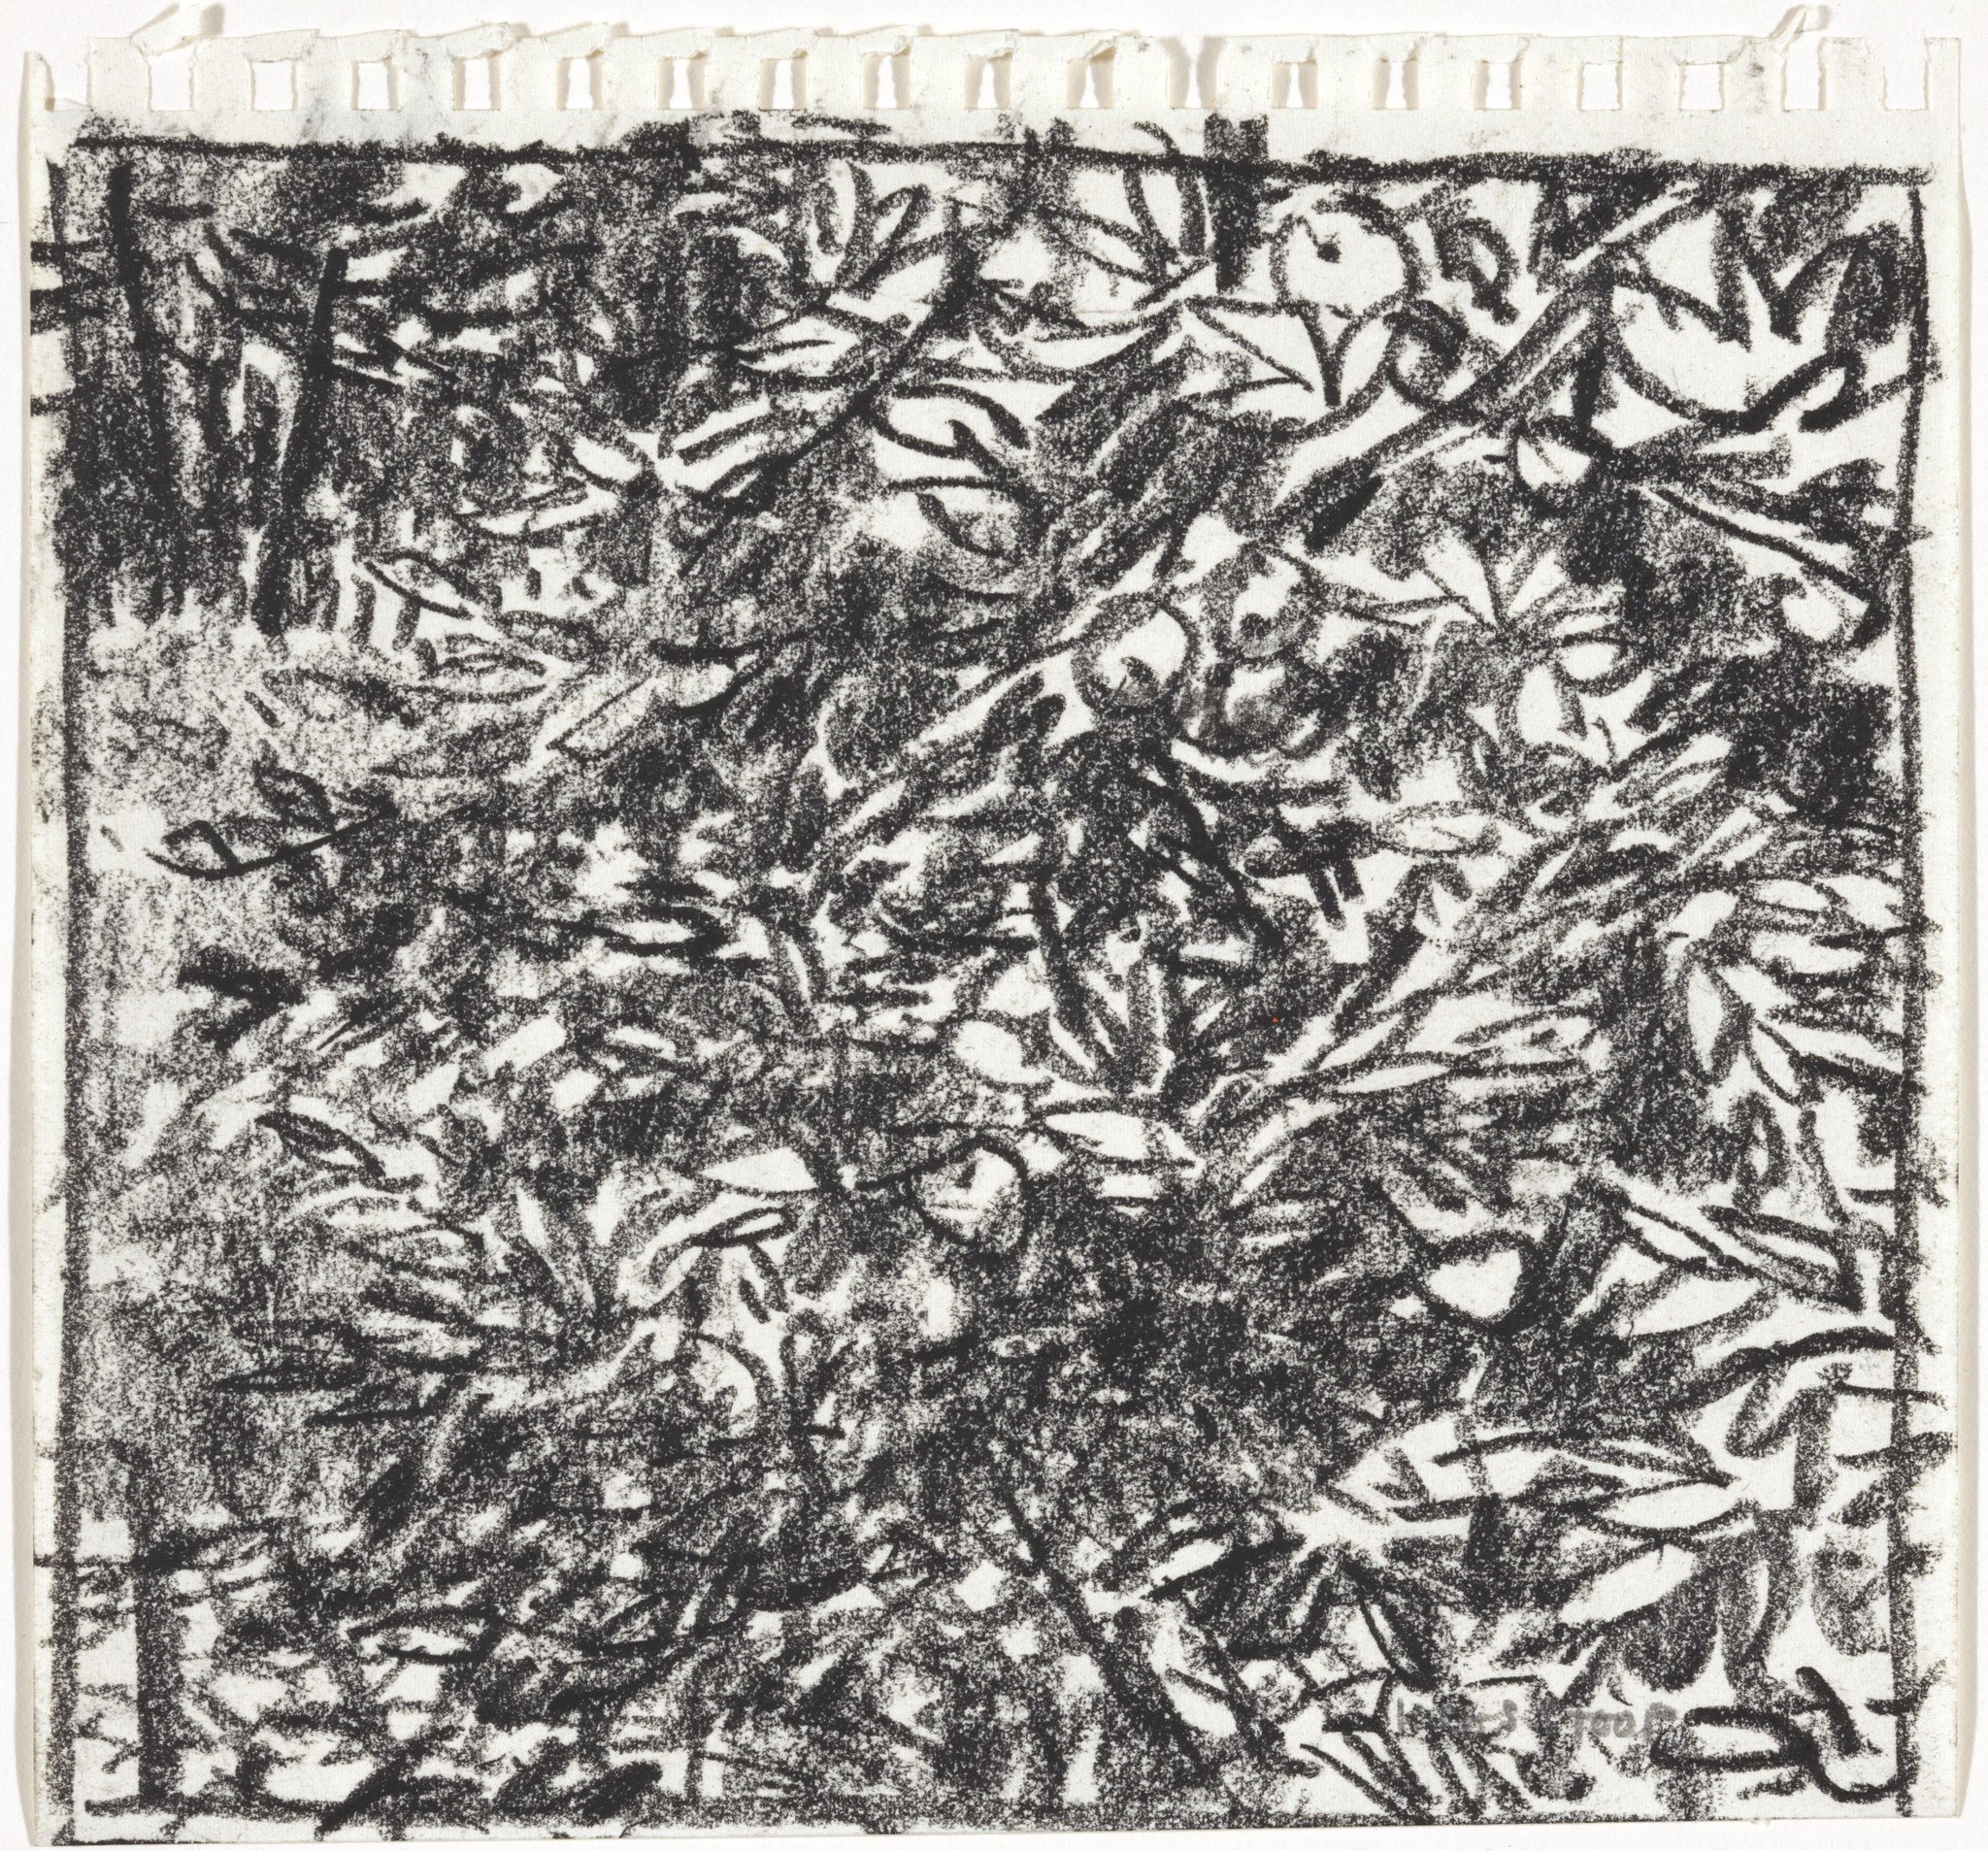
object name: drawing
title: Gebladerte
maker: kees stoop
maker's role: draughtsman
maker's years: 1929-2019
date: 1939-2009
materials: charcoal, paper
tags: forest, wood